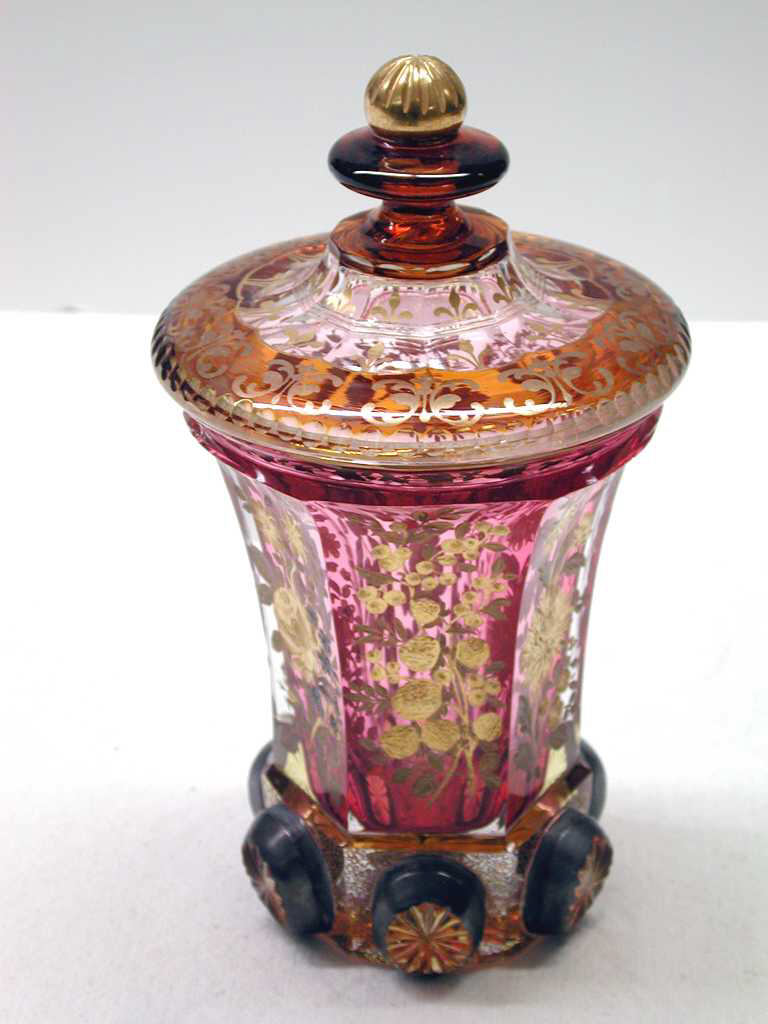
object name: goblet with cover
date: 1830-1840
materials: glass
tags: flowers